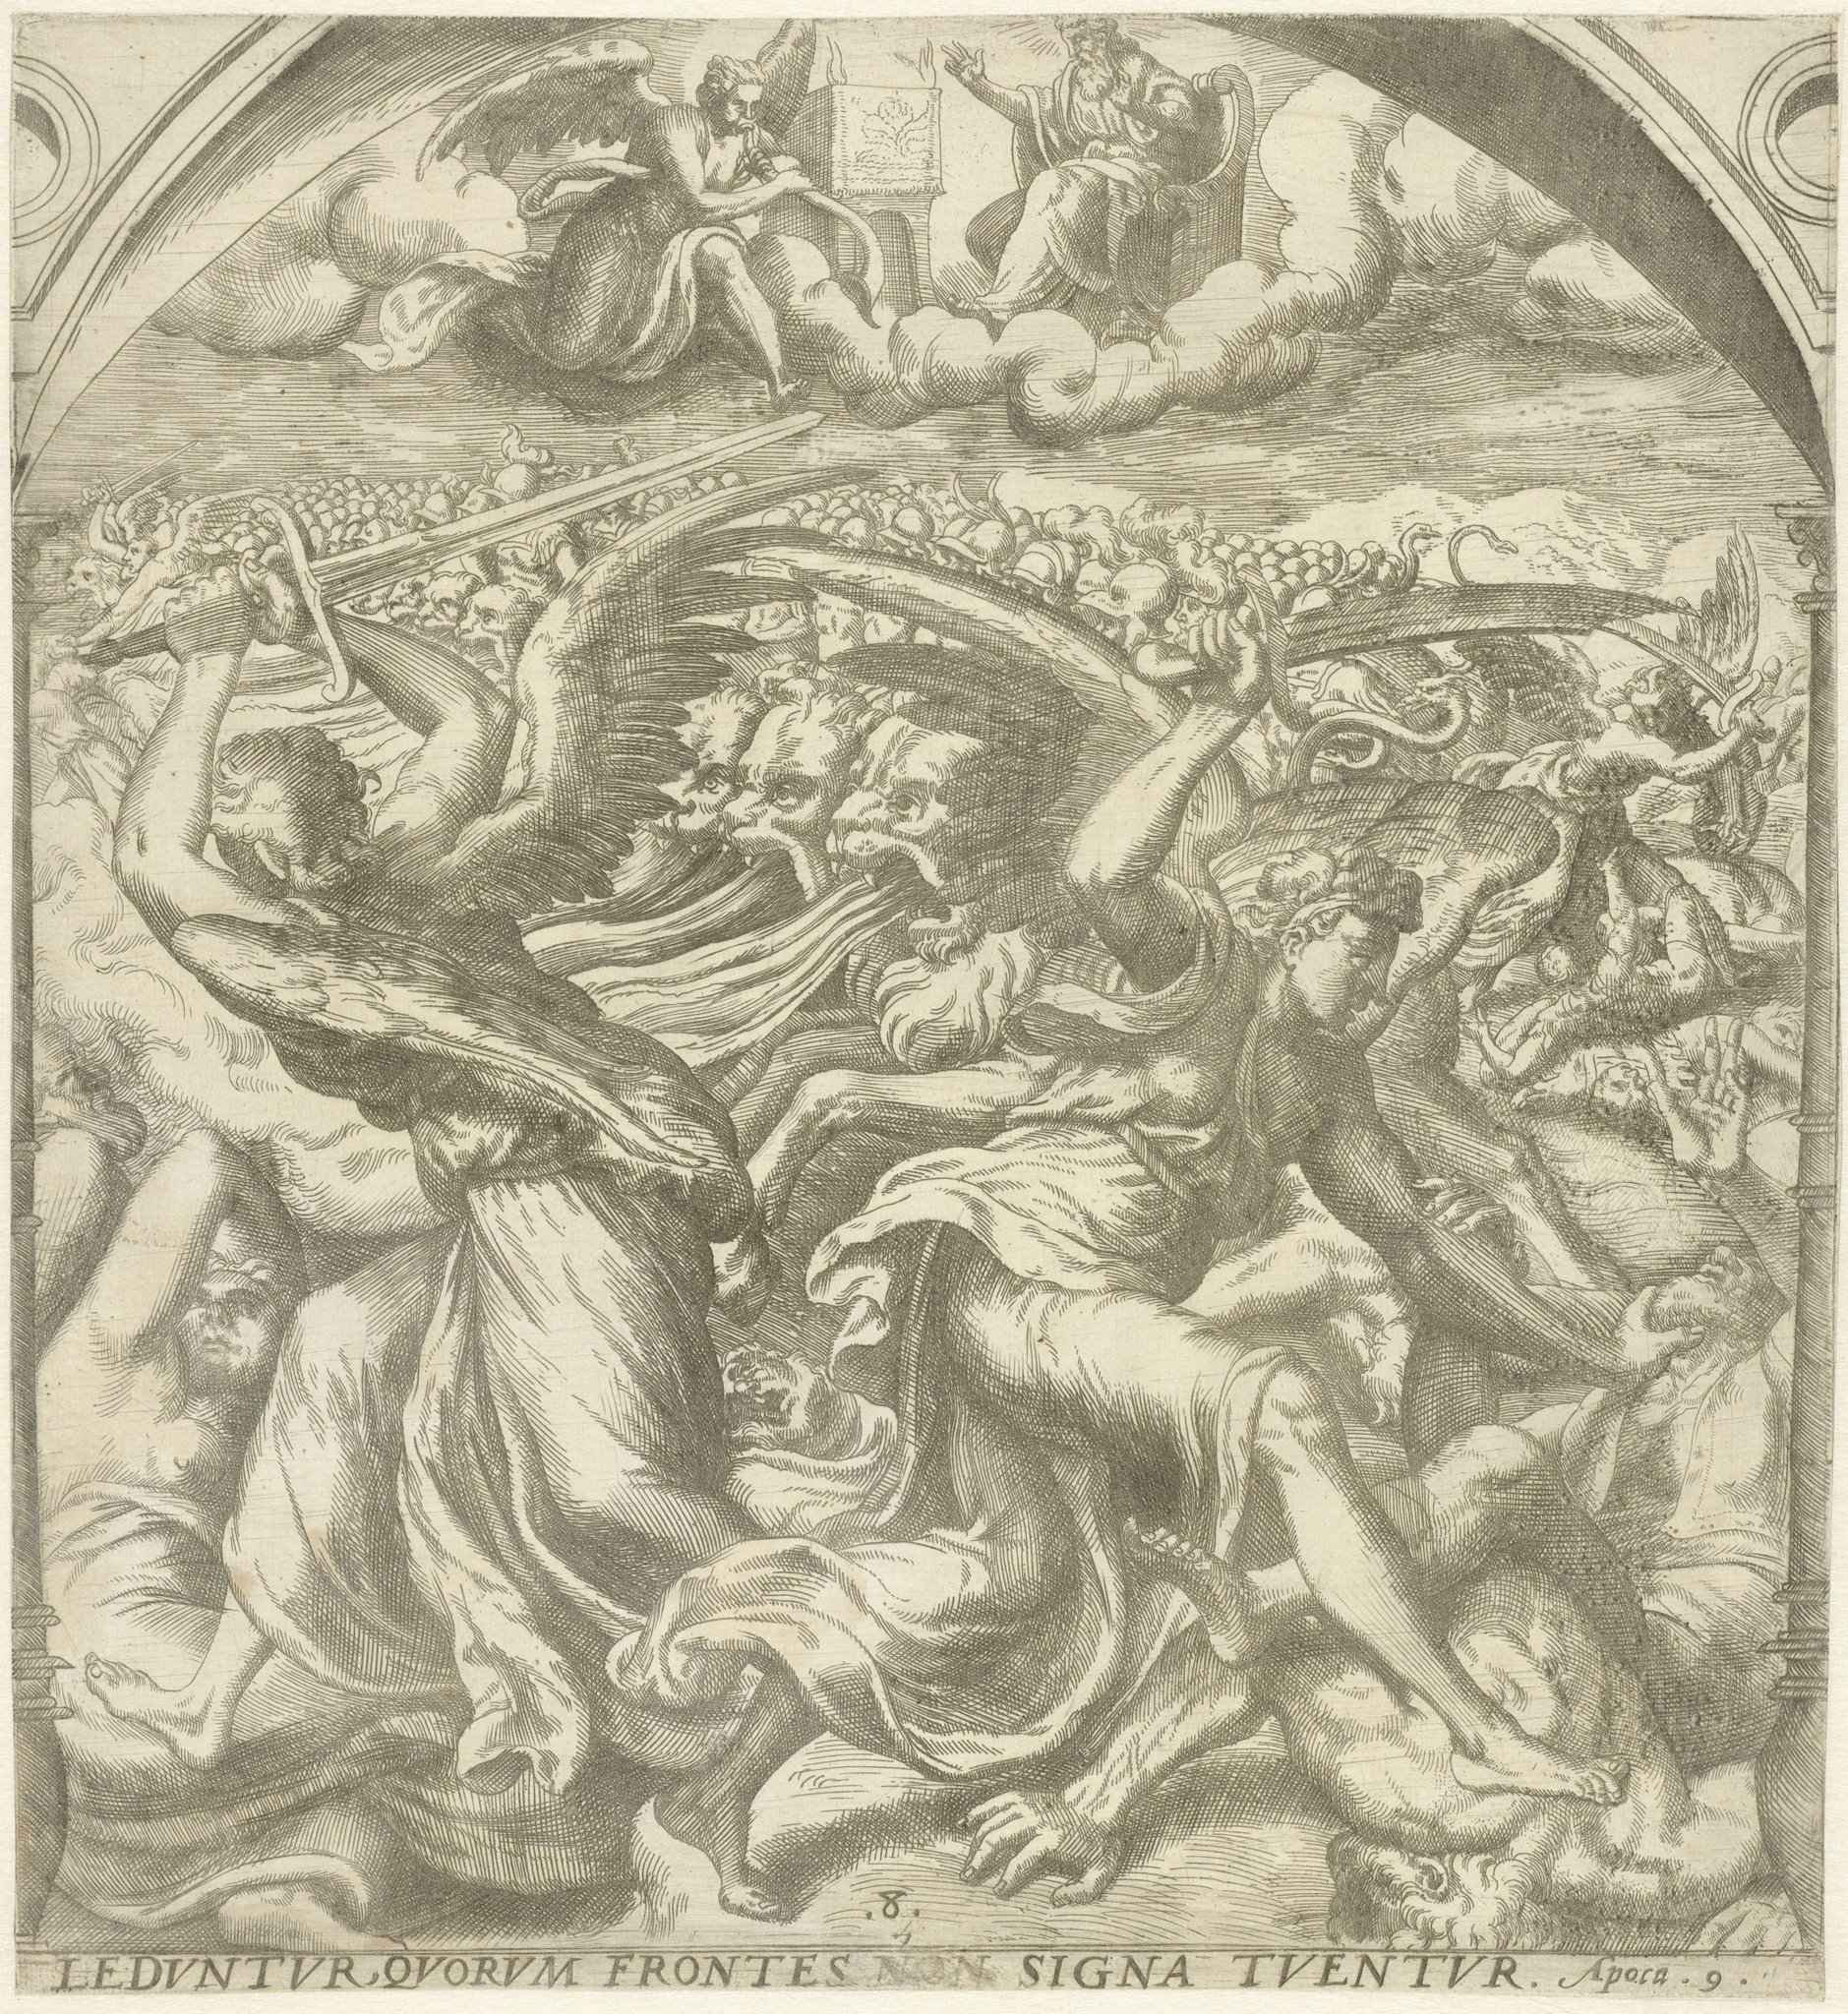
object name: print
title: Openbaring van Johannes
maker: gerard van groeningen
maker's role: draughtsman, painter, print maker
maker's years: 1515-1599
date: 1563-1574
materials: paper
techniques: engraving, etching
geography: antwerp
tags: the army of horsemen ~ the seven angels with trumpets, the sixth of the seven angels sounds the trumpet: the four angels of destruction are released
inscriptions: collector's mark: Lugt 2228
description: In de lucht kijkt God toe hoe de zesde engel op zijn bazuin blaast. Vier doodsengelen slaan op aarde met zwaarden op de mensheid in. Op de achtergrond een cavalerie, waarvan de paarden vuurspuwende leeuwenkoppen hebben en staarten met slangenkoppen (Op. 9: 13-19).